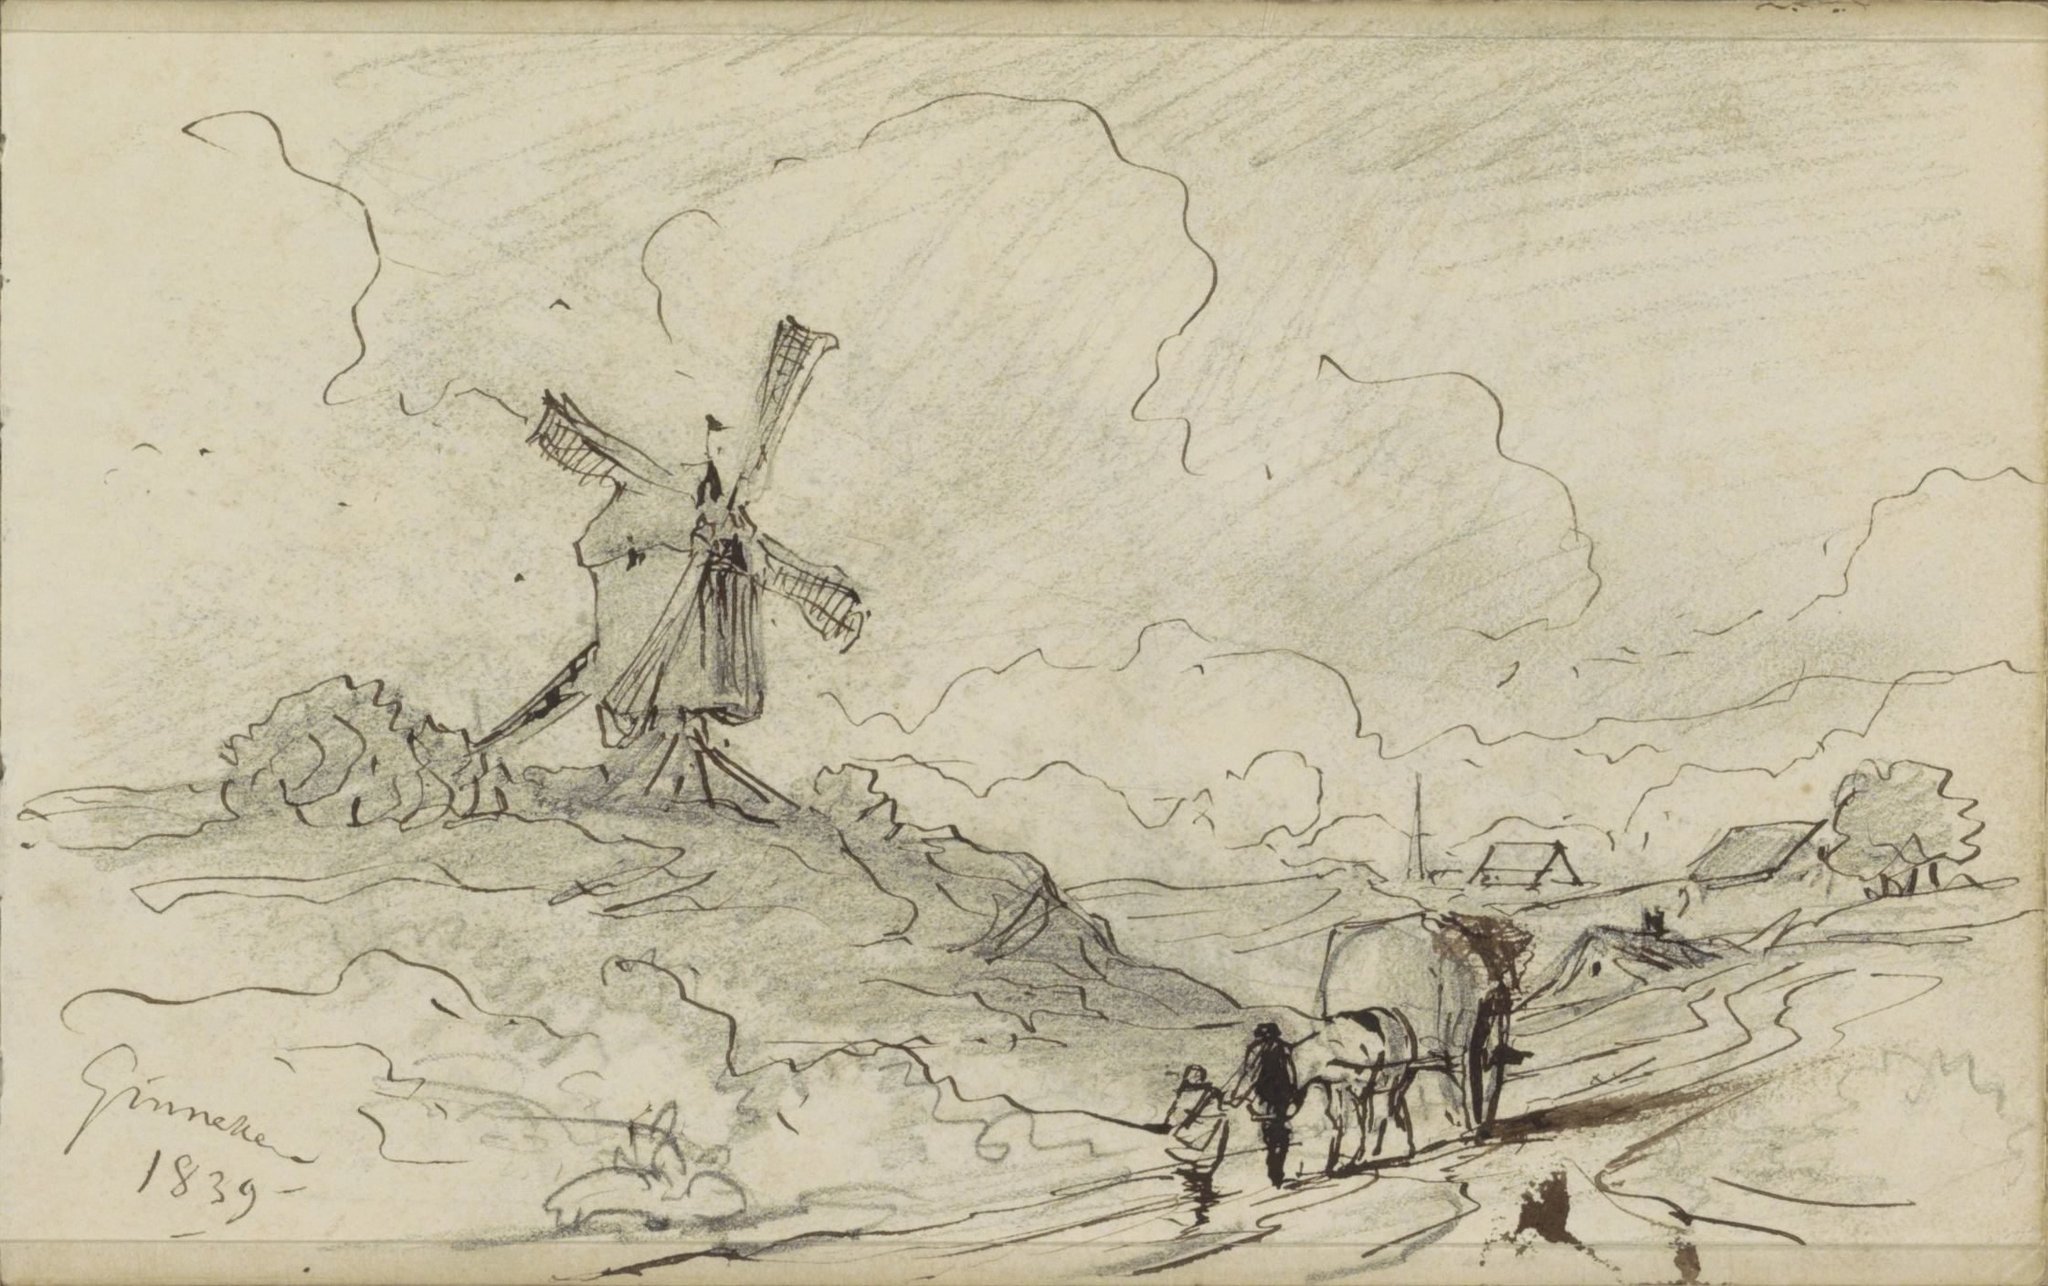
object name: sketchbook leaf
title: Landschap met molen en paard en wagen in Ginneken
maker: johannes tavenraat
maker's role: draughtsman, painter, print maker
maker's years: 1809-1881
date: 1839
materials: paper, pencil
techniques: pen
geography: ginneken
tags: city-view, and landscape with man-made constructions, four-wheeled, animal-drawn vehicle, e.g.: cab, carriage, coach, factories and mills in landscape, road, path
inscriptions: date and inscription: ‘Ginneken/ 1839’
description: Blad 27 recto uit een schetsboek met 37 bladen.